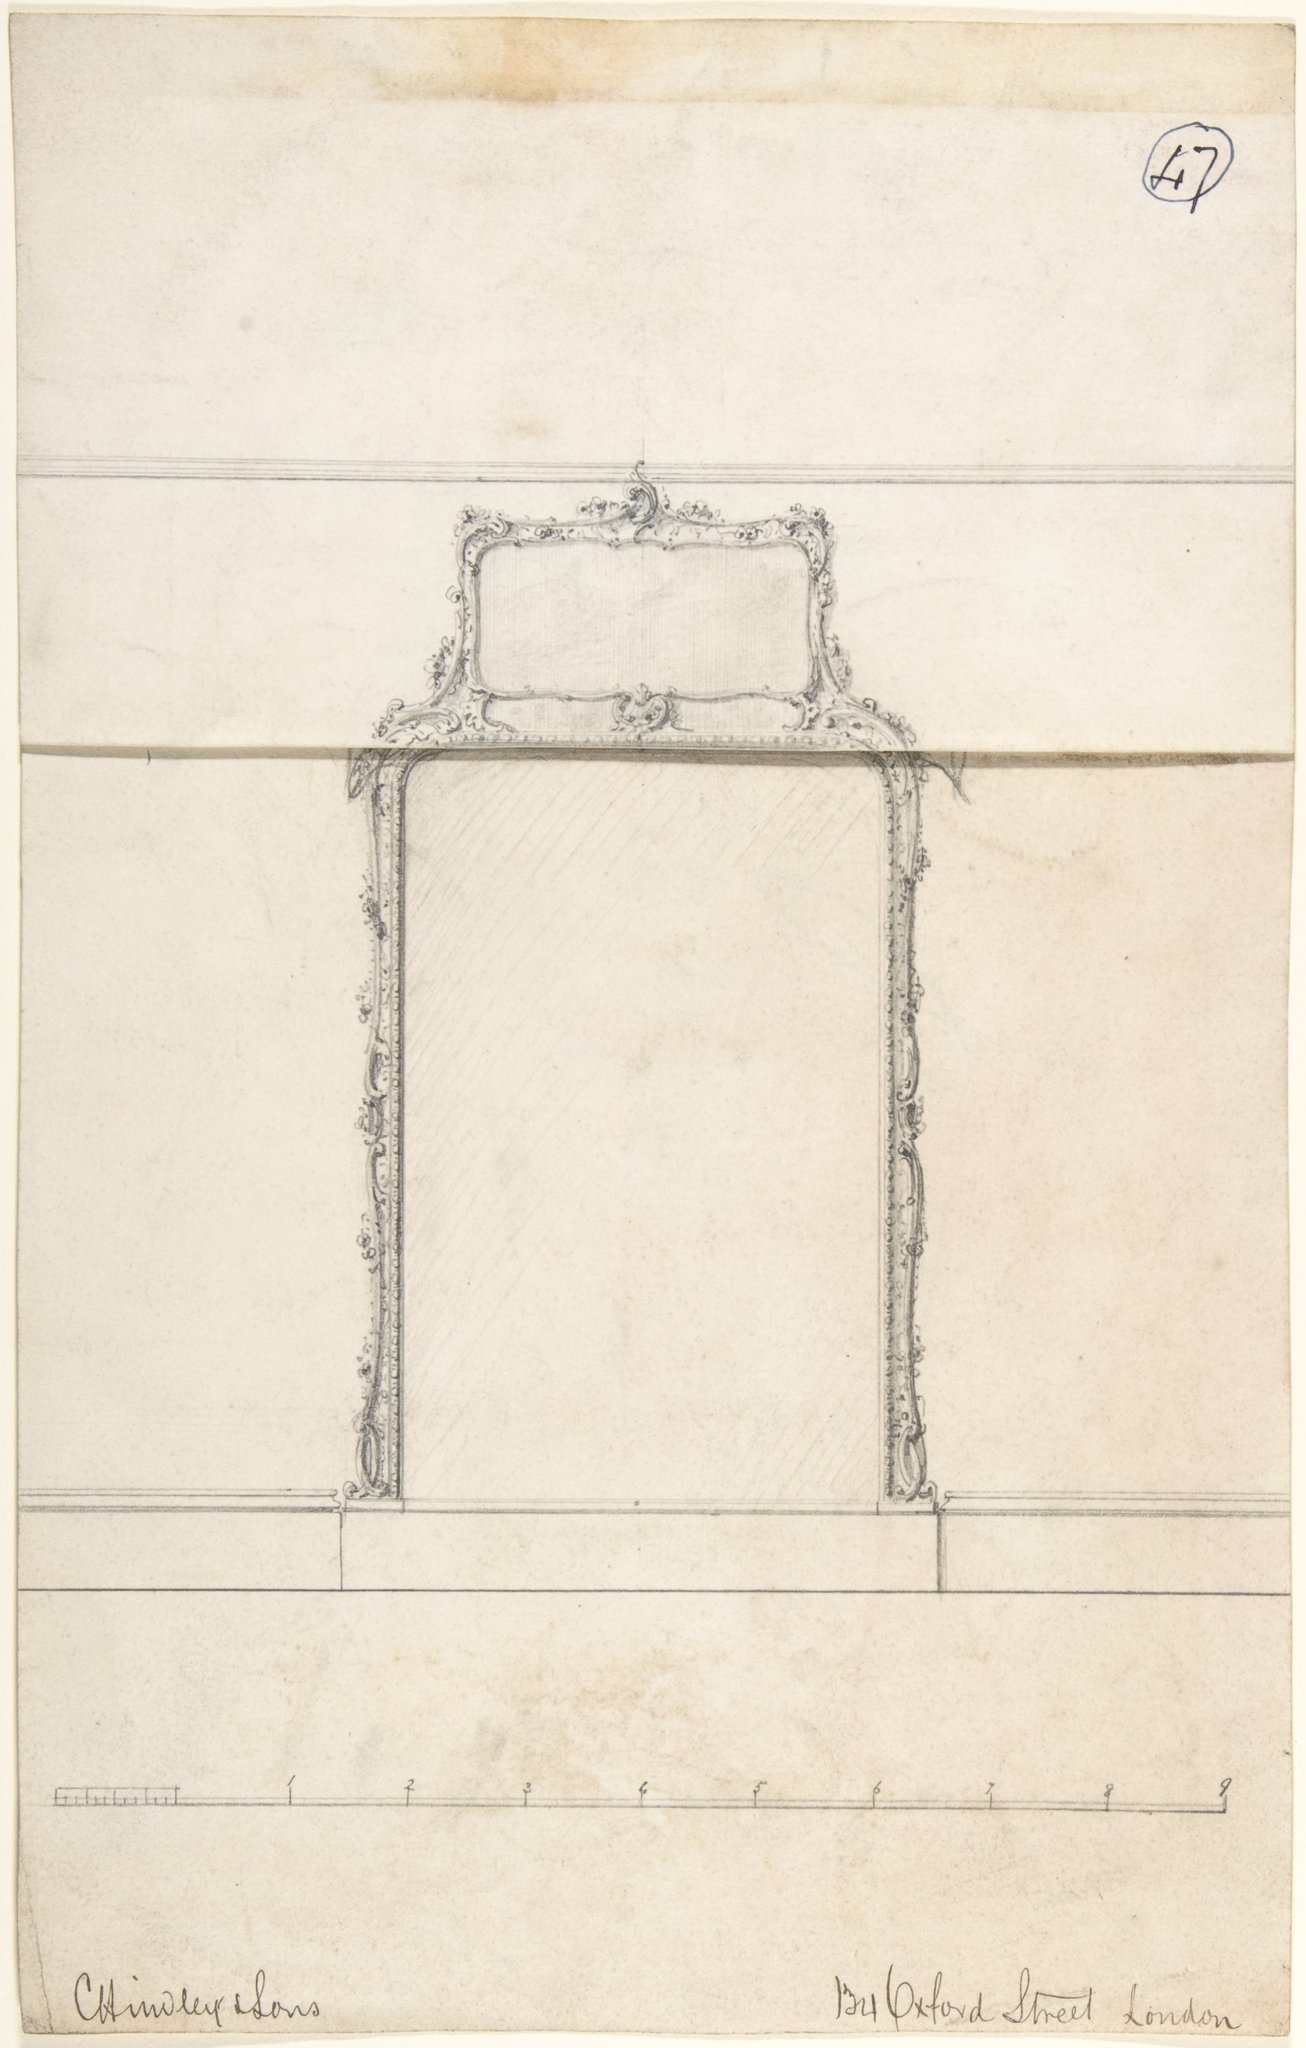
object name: drawing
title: Design for a Mirror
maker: charles hindley and sons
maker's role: artist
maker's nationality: british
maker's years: 1841-1917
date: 1841-1884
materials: graphite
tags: mirrors